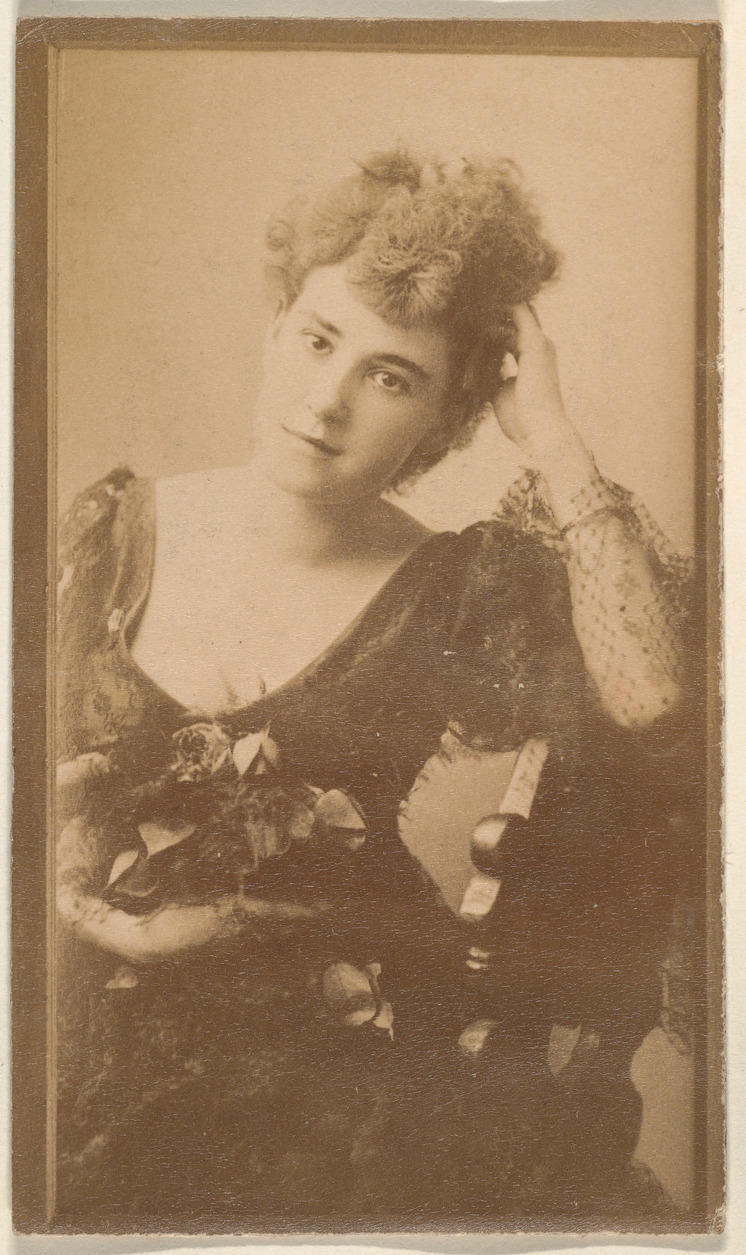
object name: photograph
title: Seated actress leaning elbow on back of chair, from the Actresses series (N668)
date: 1888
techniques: albumen silver print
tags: portraits,women,actresses